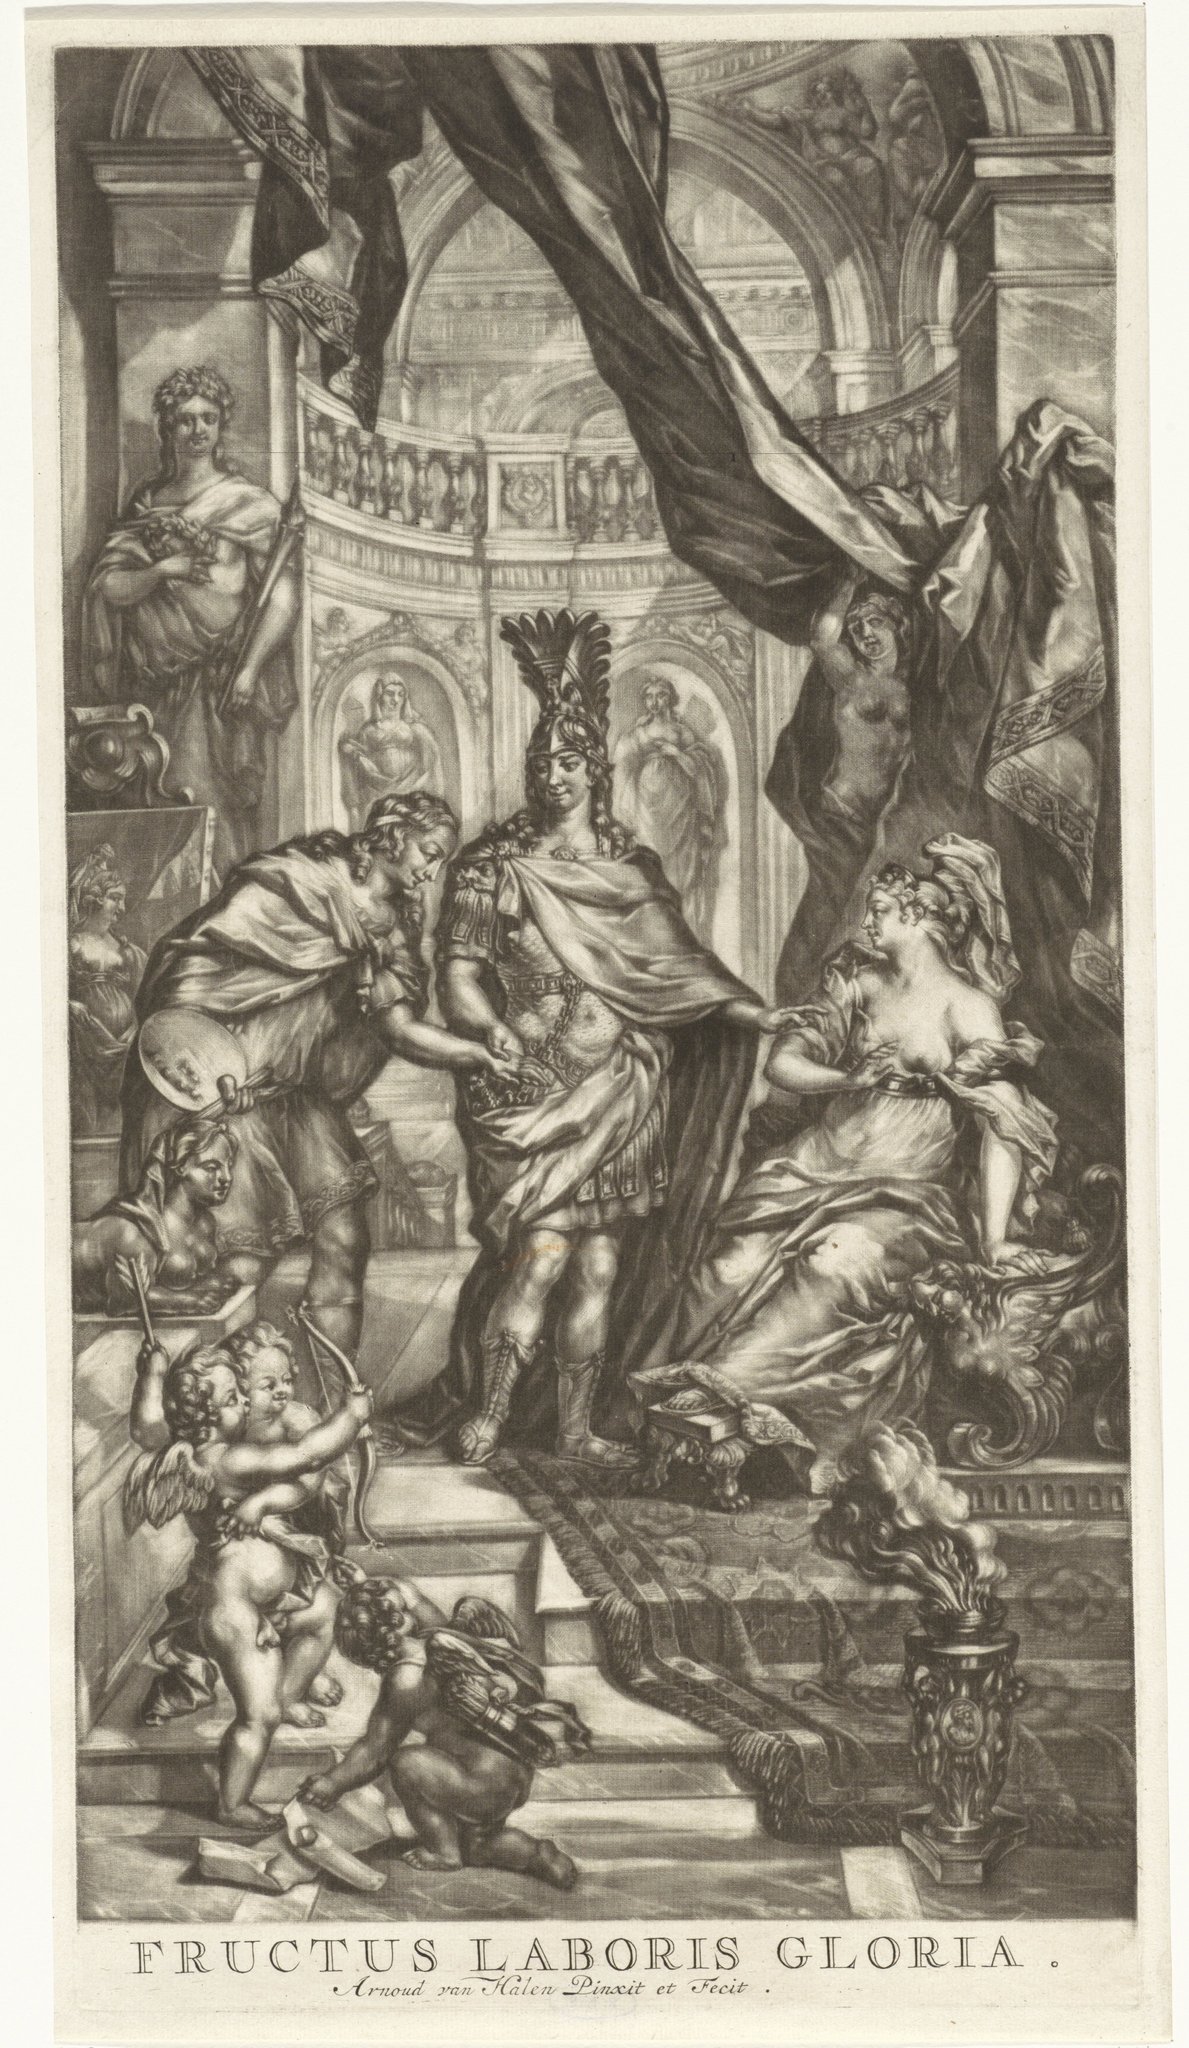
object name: print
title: Minerva leidt de Schilderkunst naar de Schoonheid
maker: arnoud van halen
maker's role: draughtsman, painter, print maker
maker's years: 1673-1732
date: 1673-1732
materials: paper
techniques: engraving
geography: amsterdam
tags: 'pictura', symbolic representations, allegories and emblems ~ painting; 'pittura' (ripa), (story of) minerva (pallas, athena), beauty; 'bellezza' (ripa)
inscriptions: collector's mark: Lugt 2228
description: Minerva leidt de personificatie van de Schilderkunst naar de personificatie van de Schoonheid. Op de voorgrond enkele putti en een wierookvat.